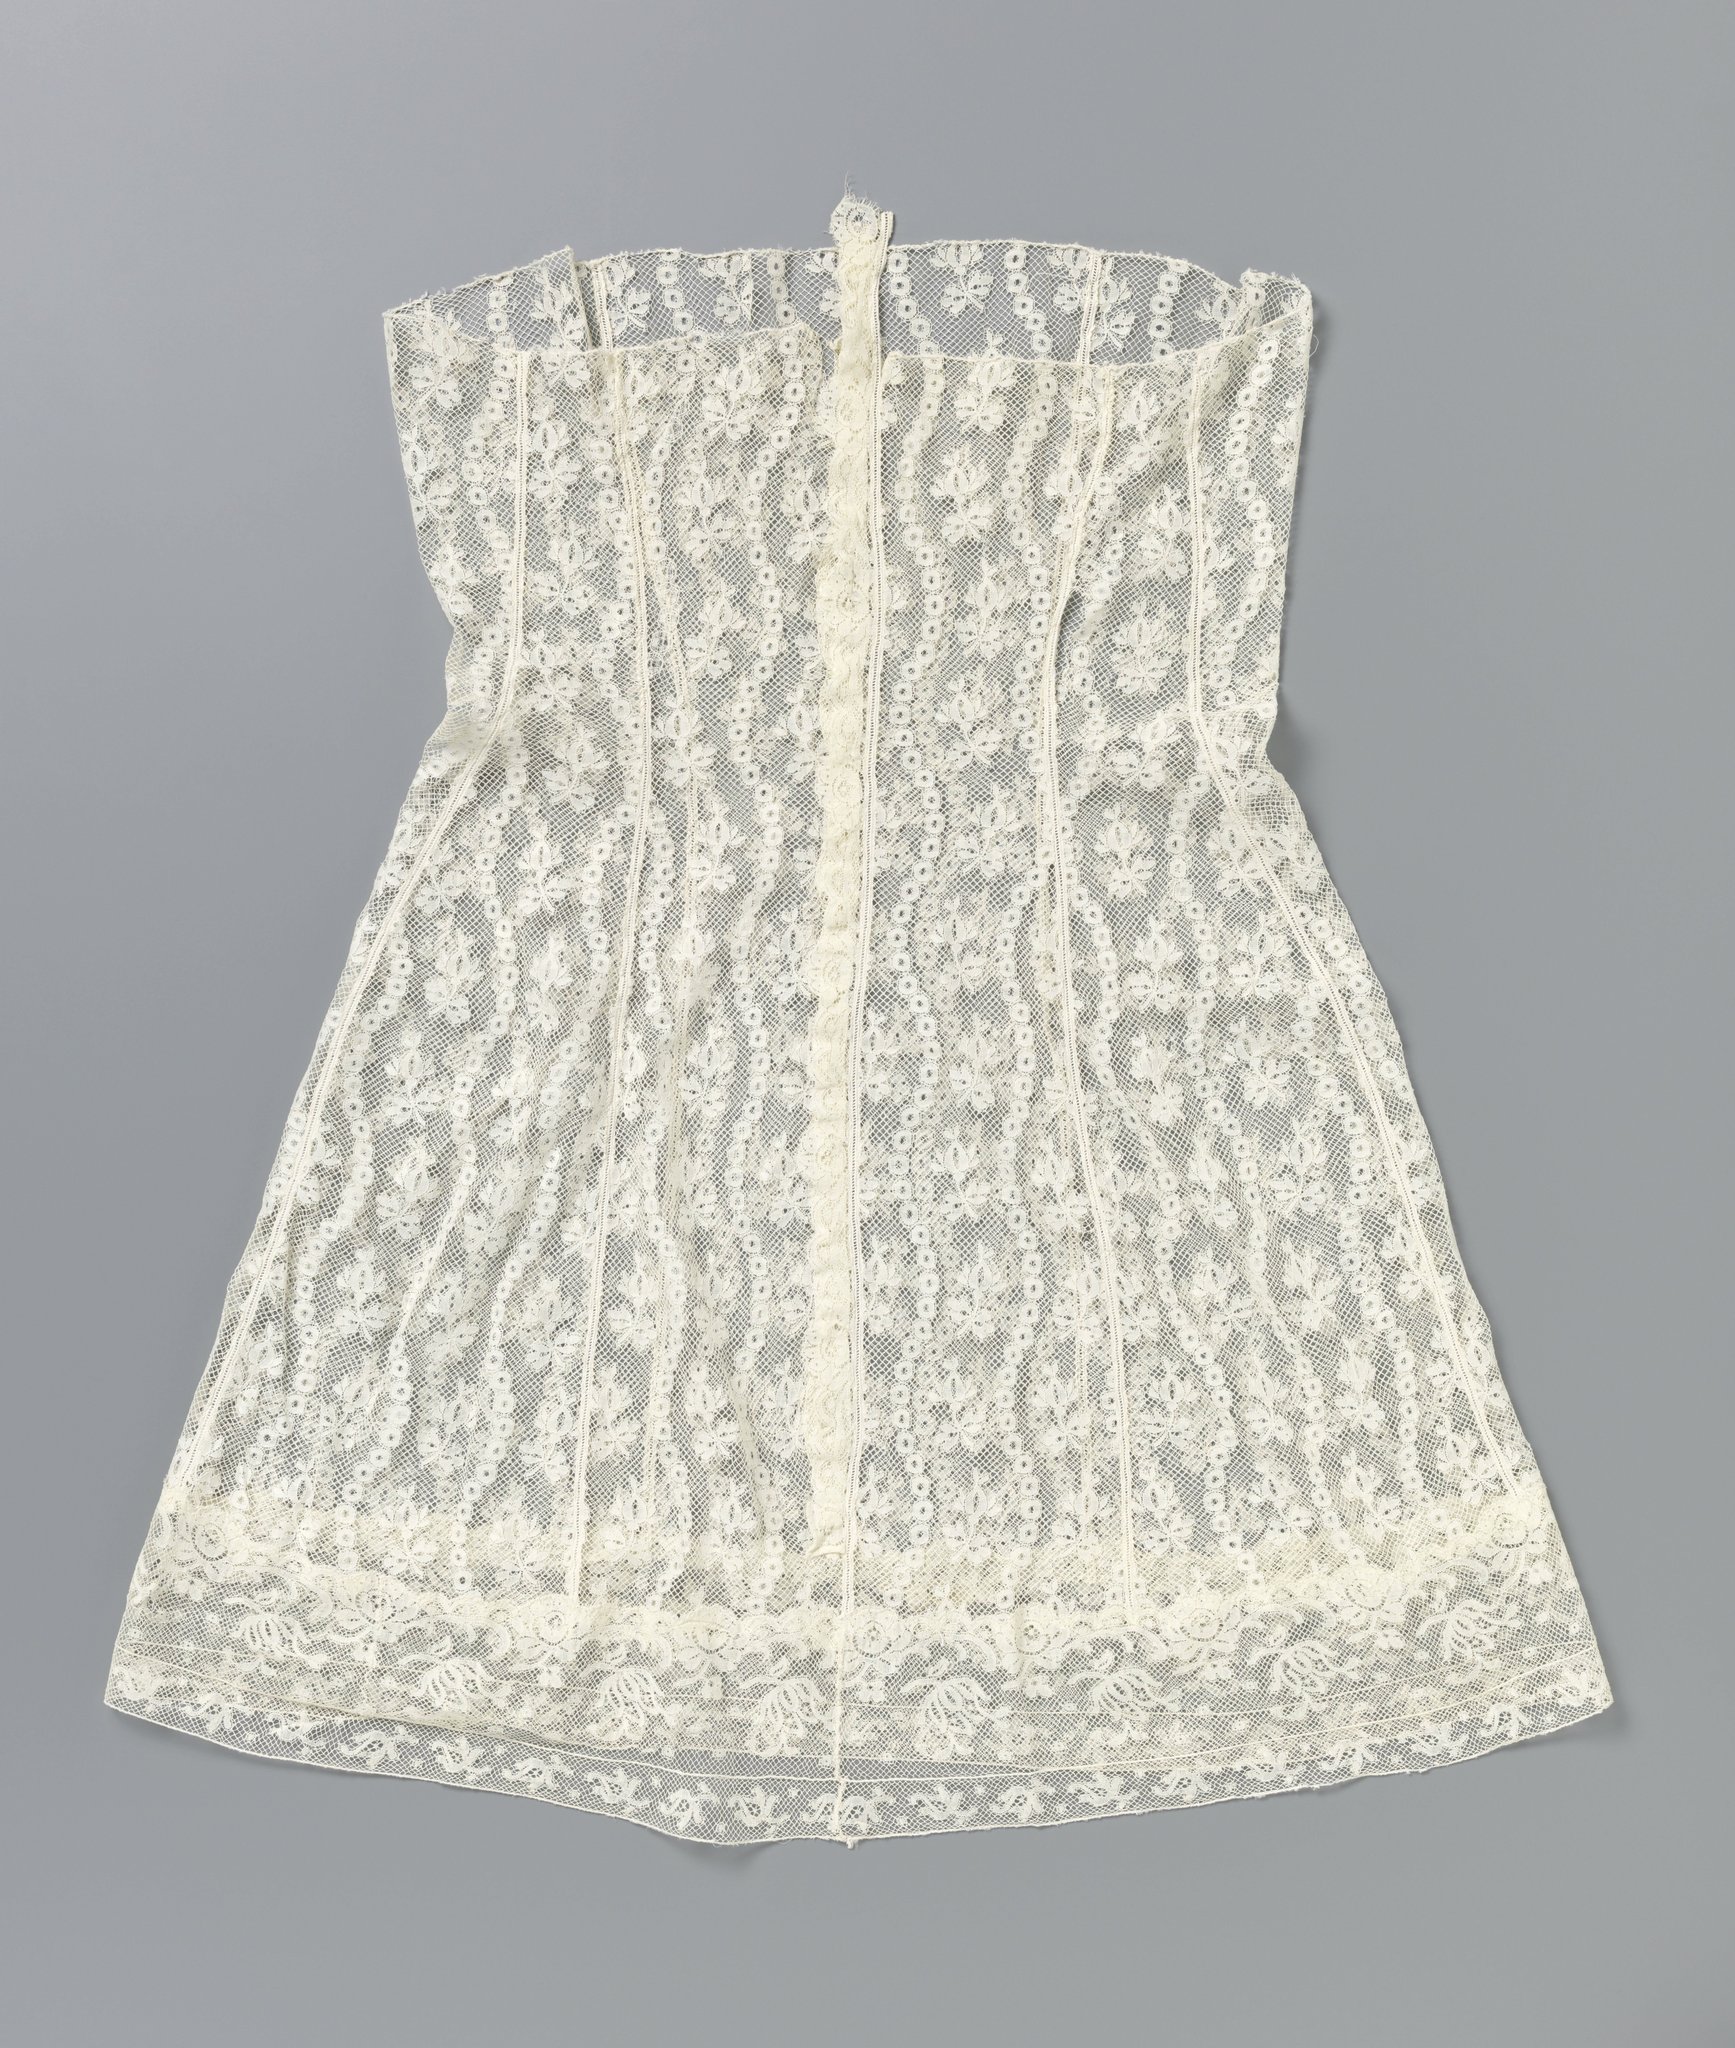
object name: underwear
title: Corset cover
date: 1910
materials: cotton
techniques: lace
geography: paris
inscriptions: address: ‘Capdeville, Guillay et Cie Guac [essen]ces, 63 Bd. Hausmann, Paris’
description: From the moment the hoop skirt (crinoline) went out of fashion in Paris in the 1860s, Dutch women had their metal hoops bent backwards into an oval by the blacksmith. A long, slender silhouette with emphasis on the buttocks was now expected and so the bustle (tournure) began its rise, sometimes incorporated into a skirt but also as a loose piece fastened around the waist.